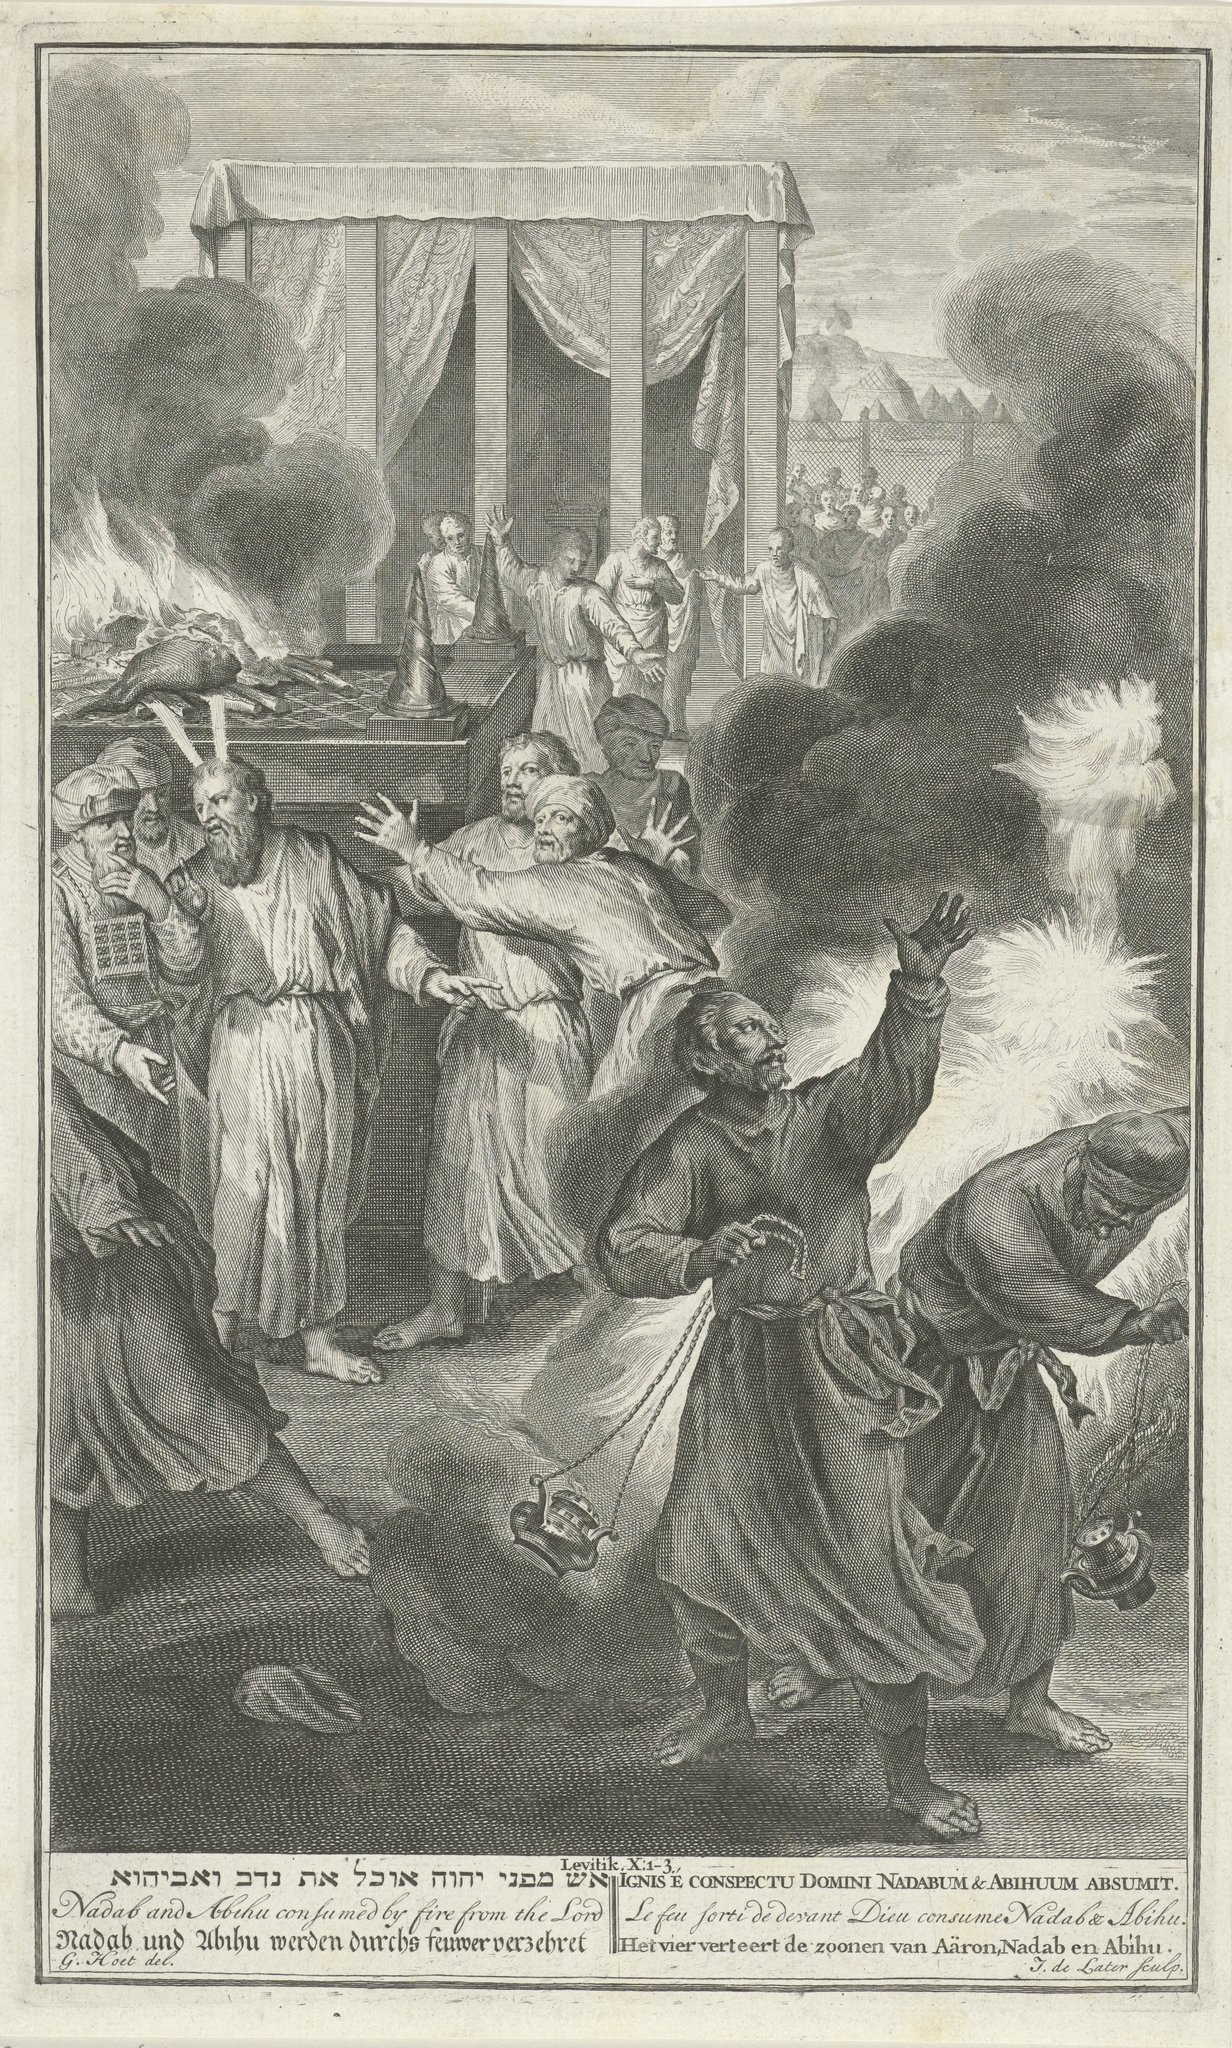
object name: print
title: Nadab en Abihu gedood door vlammen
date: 1728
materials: paper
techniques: engraving, etching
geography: amsterdam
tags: two sons of aaron, nadab and abihu, offer incense in their censers to god, who punishes them for this by sending a fire that kills them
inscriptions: collector's mark: Lugt 2228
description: Prent gemaakt voor: Figures de la Bible. Amsterdam, Bernard Picart, 1720. Prent ook gebruikt in: Taferelen der voornaamste geschiedenissen van het Oude en Nieuwe Testament (...) door de vermaarde kunstenaars Hoet, Houbraken, en Picart getekent (...) en met beschrijvingen uitgebreid. Den Haag: Pieter de Hondt, 1728.